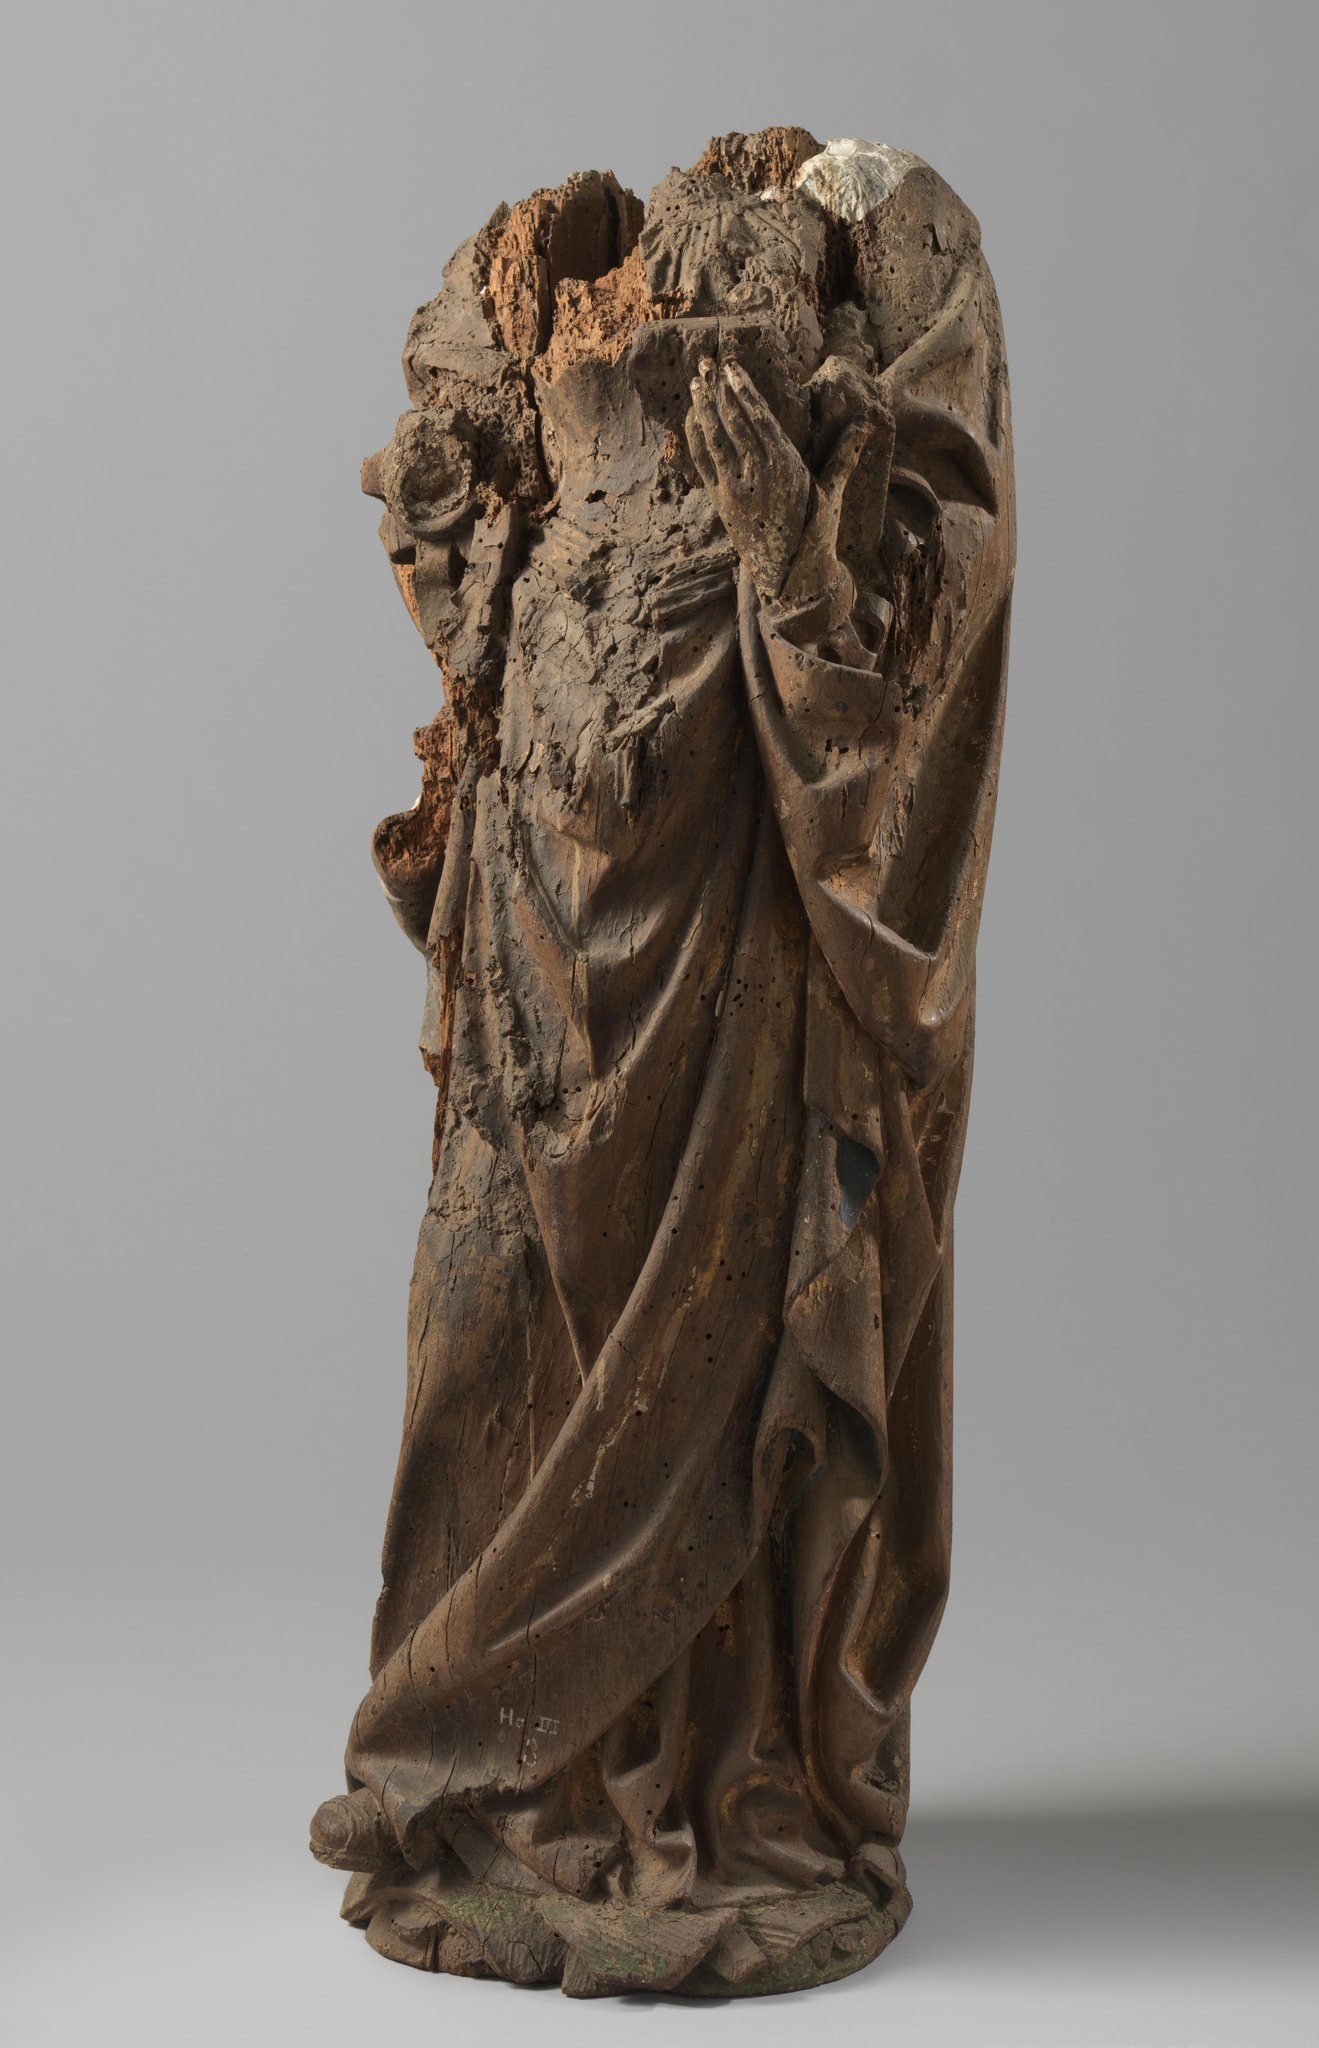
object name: sculpture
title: Female Saint (St Agatha?)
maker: Anonymous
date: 1500-1520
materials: wood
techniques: gilding, polychromy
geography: utrecht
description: Zij staat met de rechtervoet iets naar voren op een grondje en houdt in de linkerhand een fragment van een opengeslagen boek. Onder het keurs met uitgeschulpte halsuitsnijding en met mouwen, voorzien van splitten, een dun geplooid hemd. Van de schouders hangt de mantel, die bij de armen is opgenomen. Onder de rok van het keurs de stompe rechterschoenpunt en deel van onderkleed. Voor het middel een afhangende sjerp. Het hoofd ontbreekt.